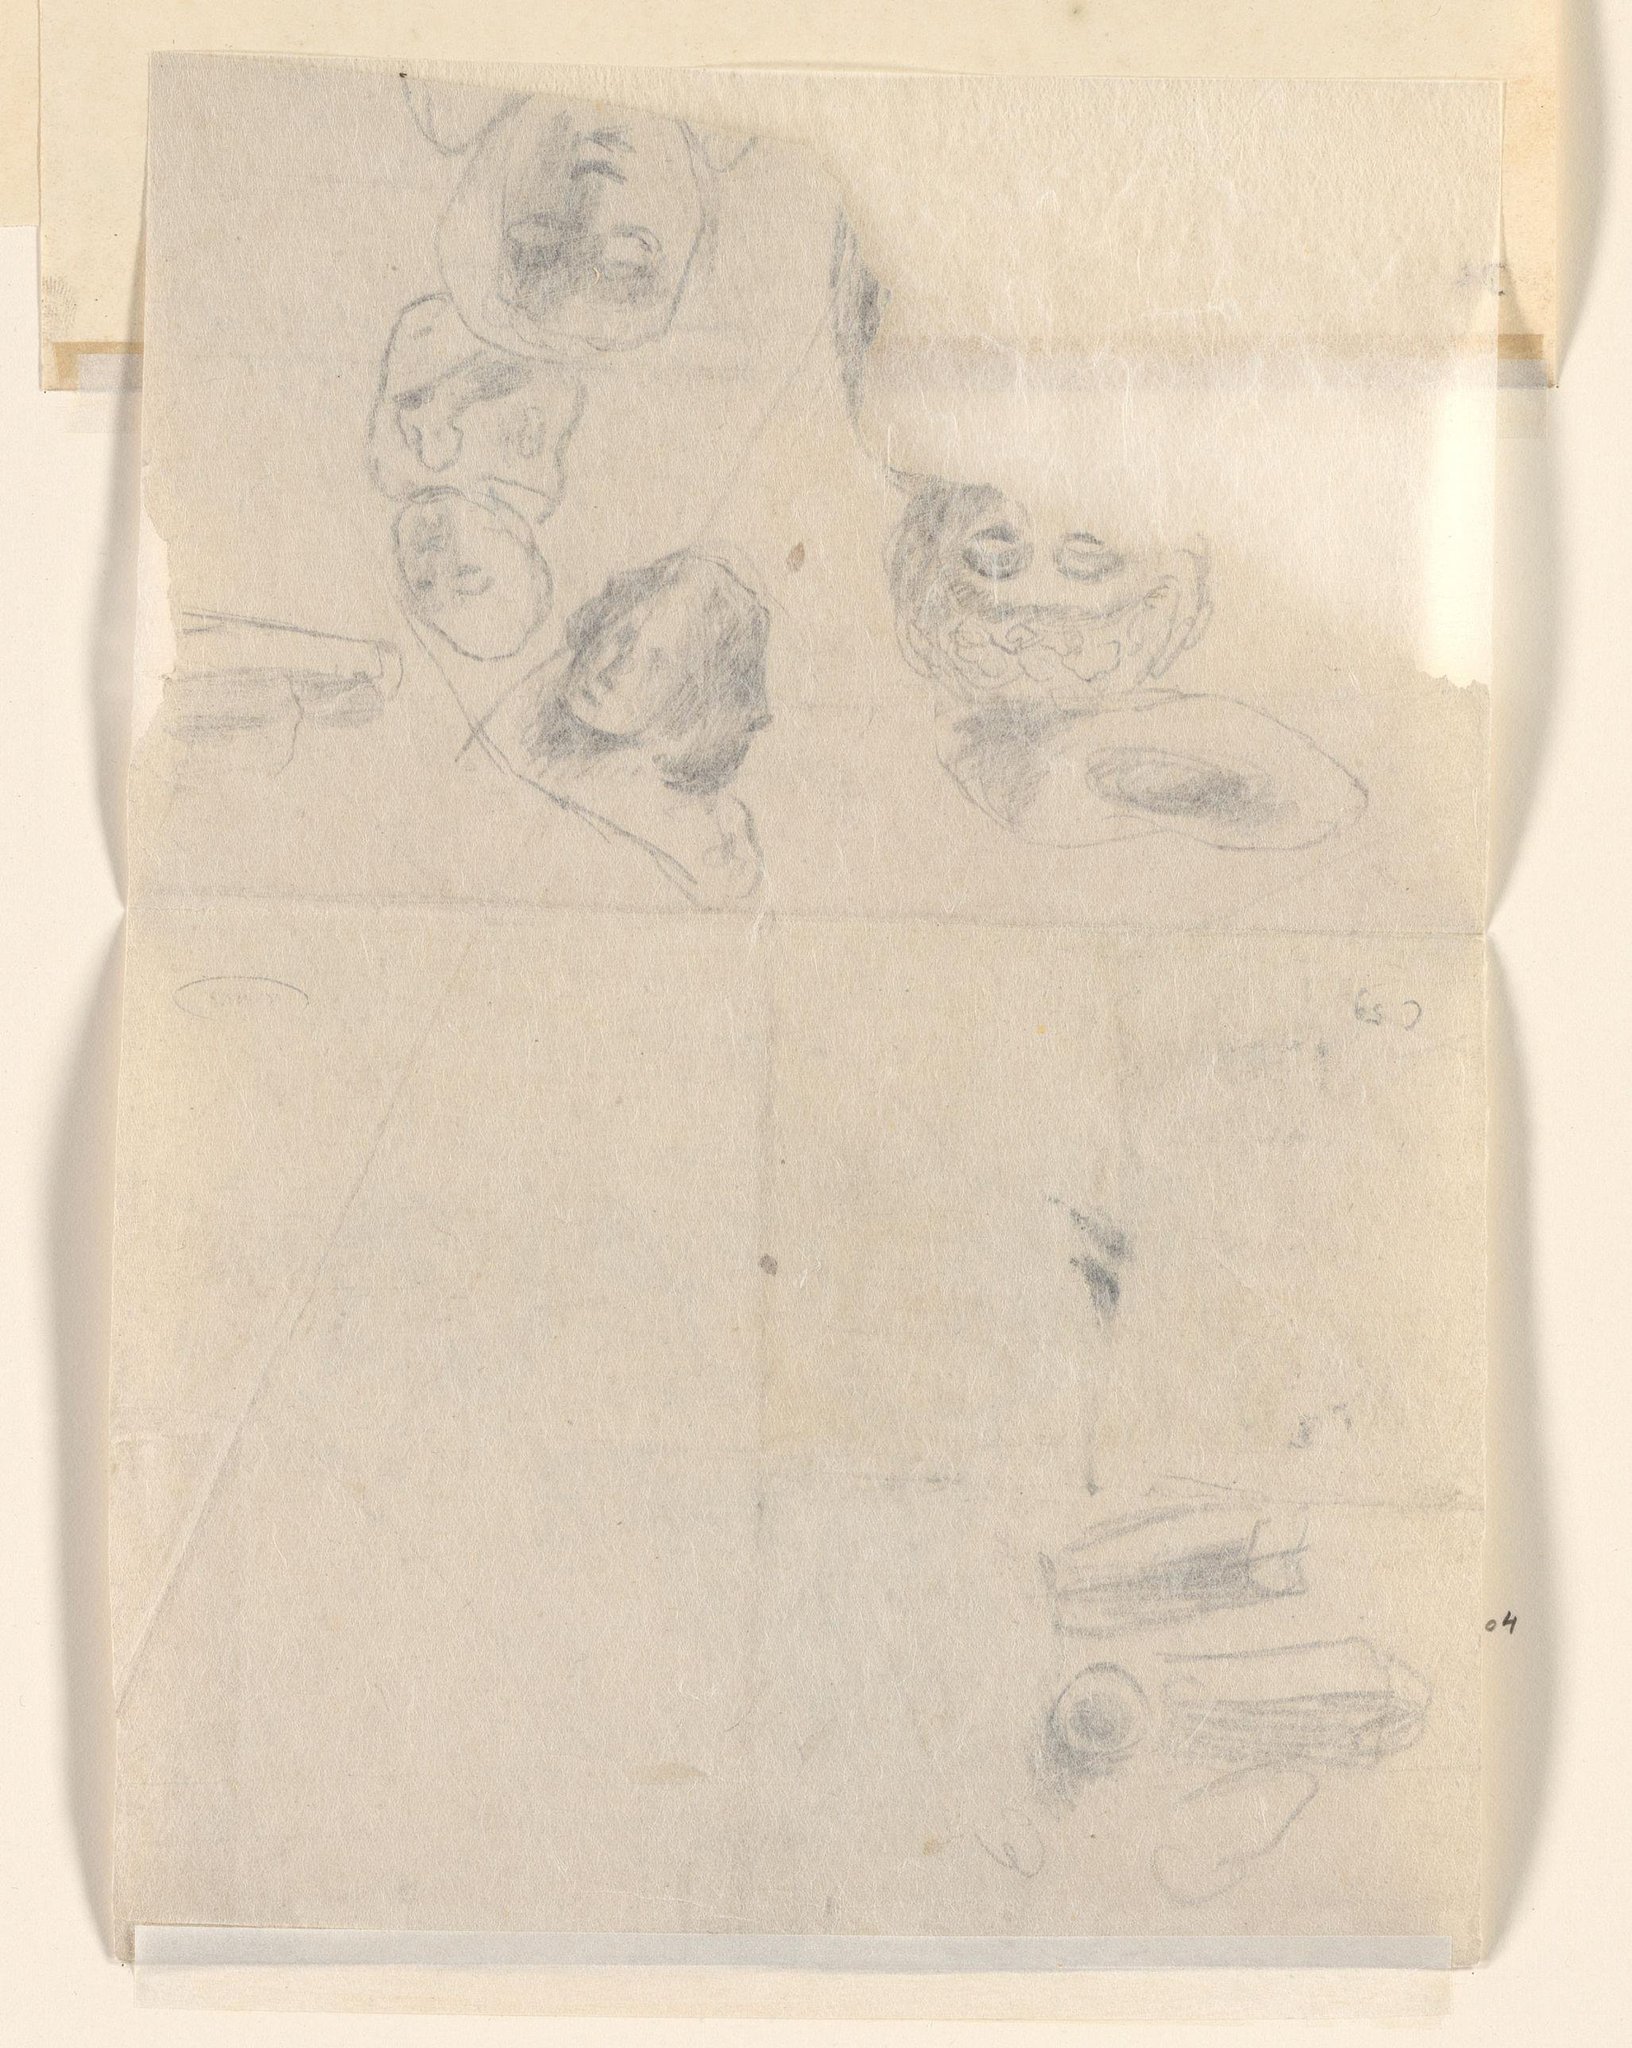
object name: drawing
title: Schetsen van beeldenkoppen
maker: adrianus johannes bik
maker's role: draughtsman, print maker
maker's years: 1790-1872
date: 1819-1824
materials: chalk, paper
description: artikel over deze collectie in Bulletin van het Rijksmuseum 49 [2001], nr. 4, pp. 342 e.v.